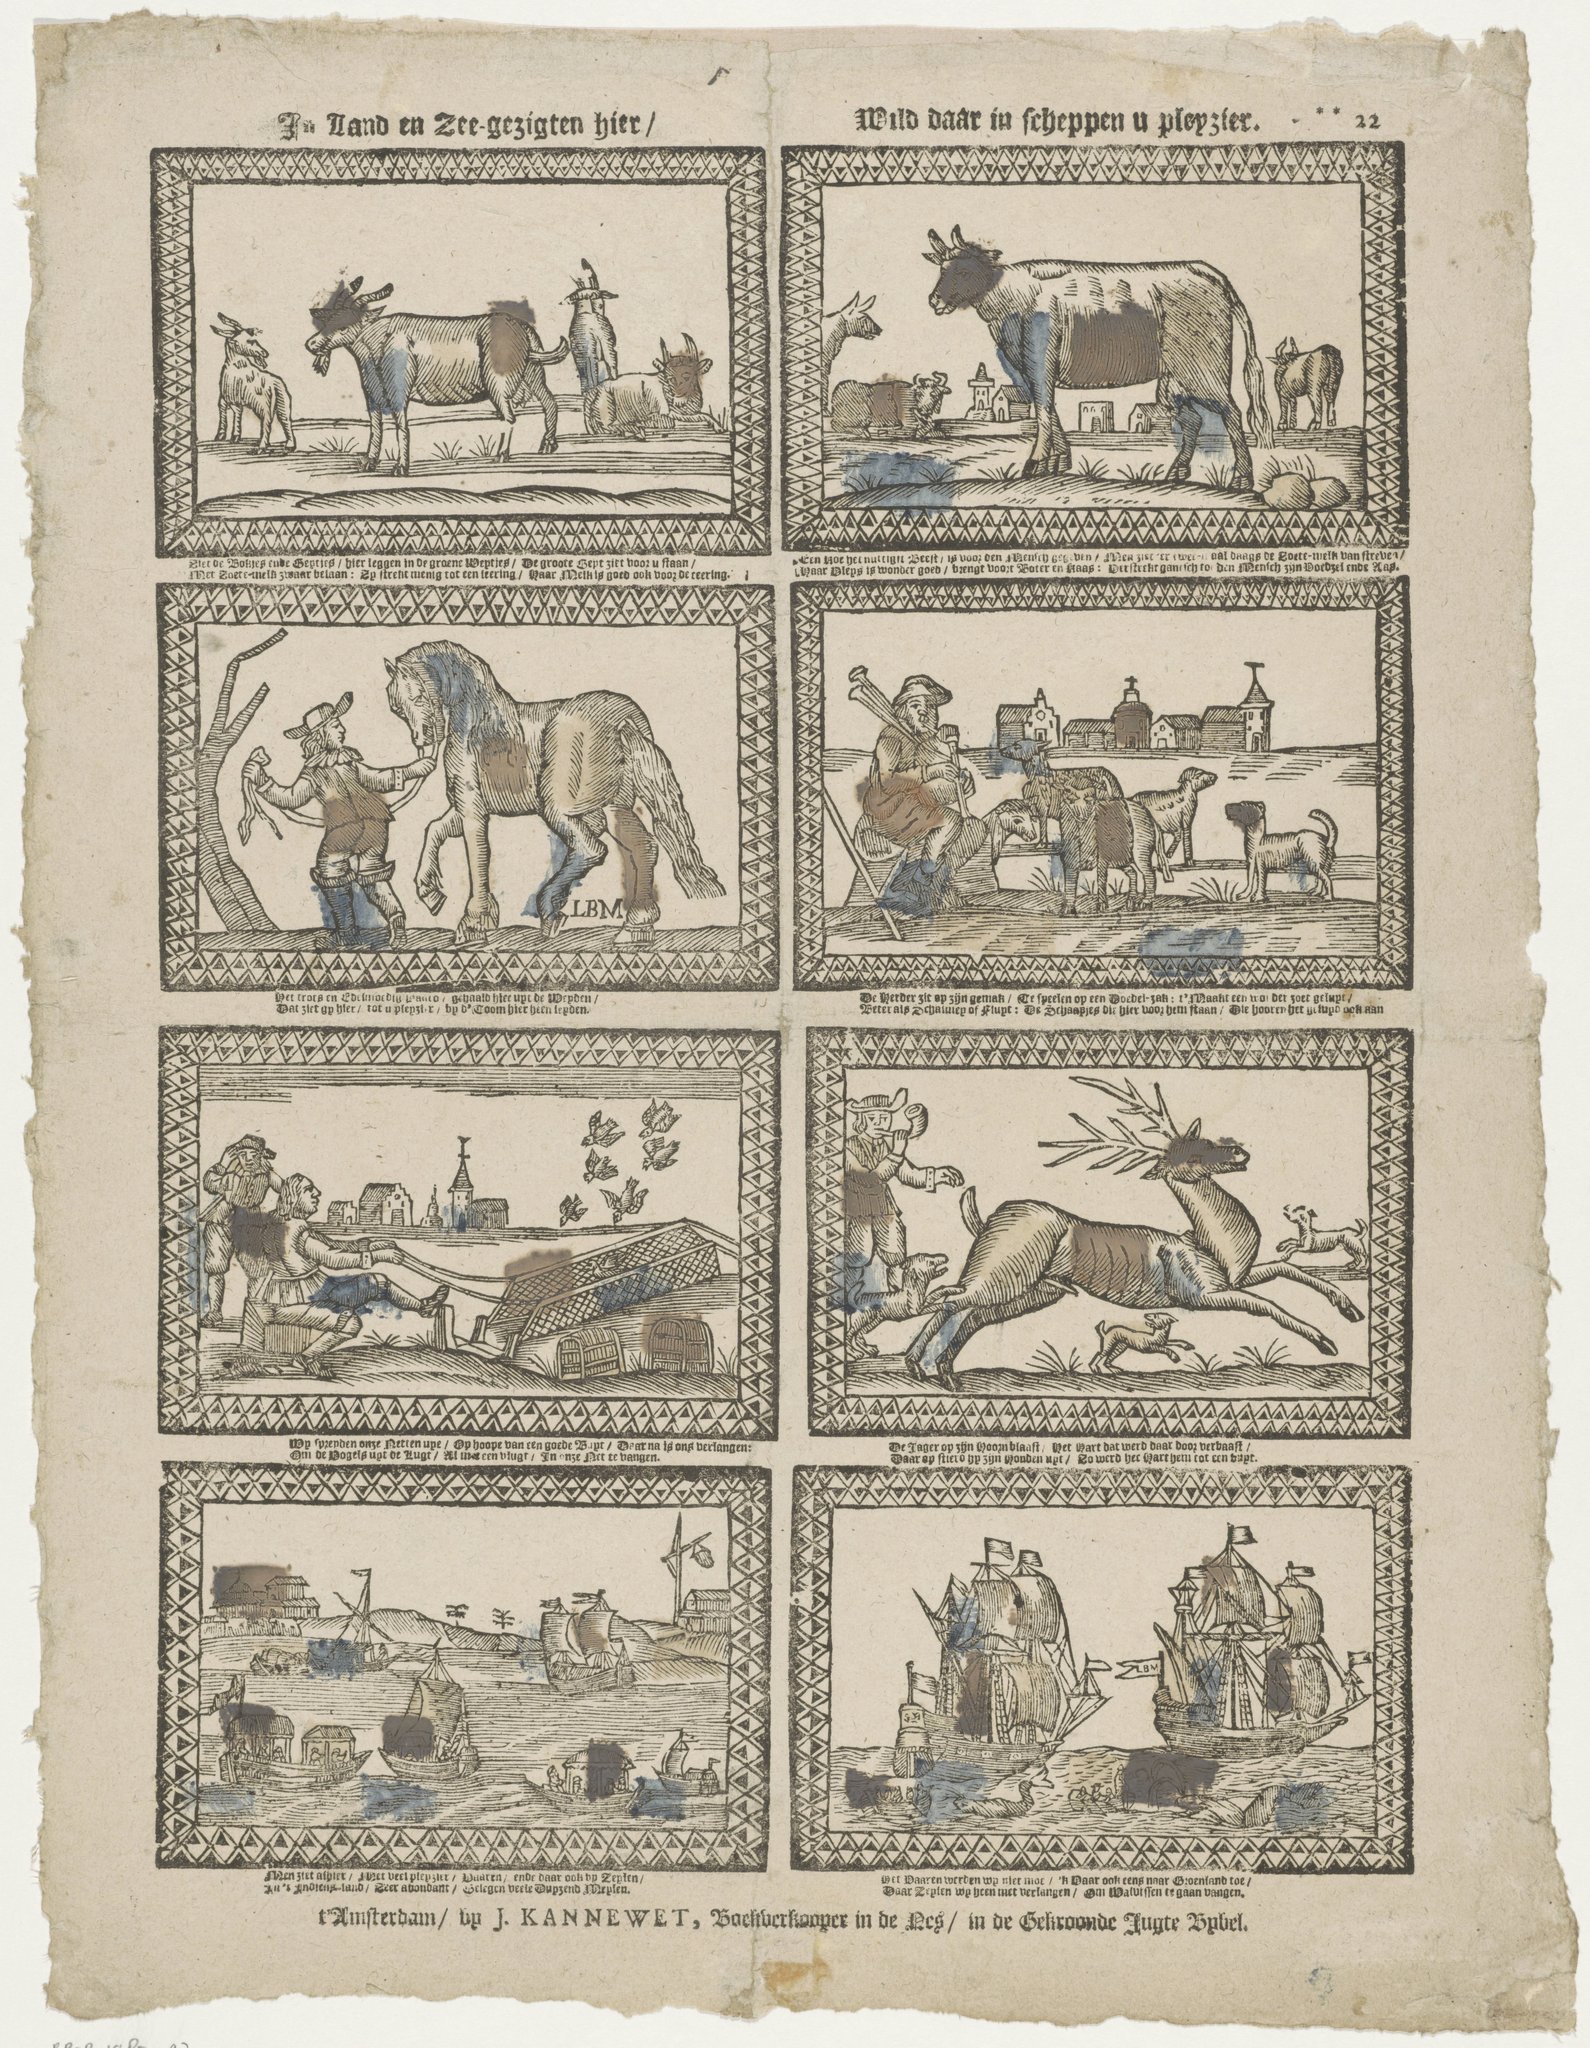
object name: popular print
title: In land en zee-gezigten hier / Wild daar in scheppen u pleyzier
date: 1725-1780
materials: paper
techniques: colour, letterpress printing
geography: amsterdam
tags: cow, animals, farmers, ships (in general), horse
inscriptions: collector's mark: Lugt 2760, collector's mark: Lugt 2228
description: Blad met 8 voorstellingen van boeren en dieren op het platteland en van schepen op zee. Elke voorstelling is gevat in een sierlijst. Onder elke afbeelding een onderschrift. Genummerd rechtsboven: **22.